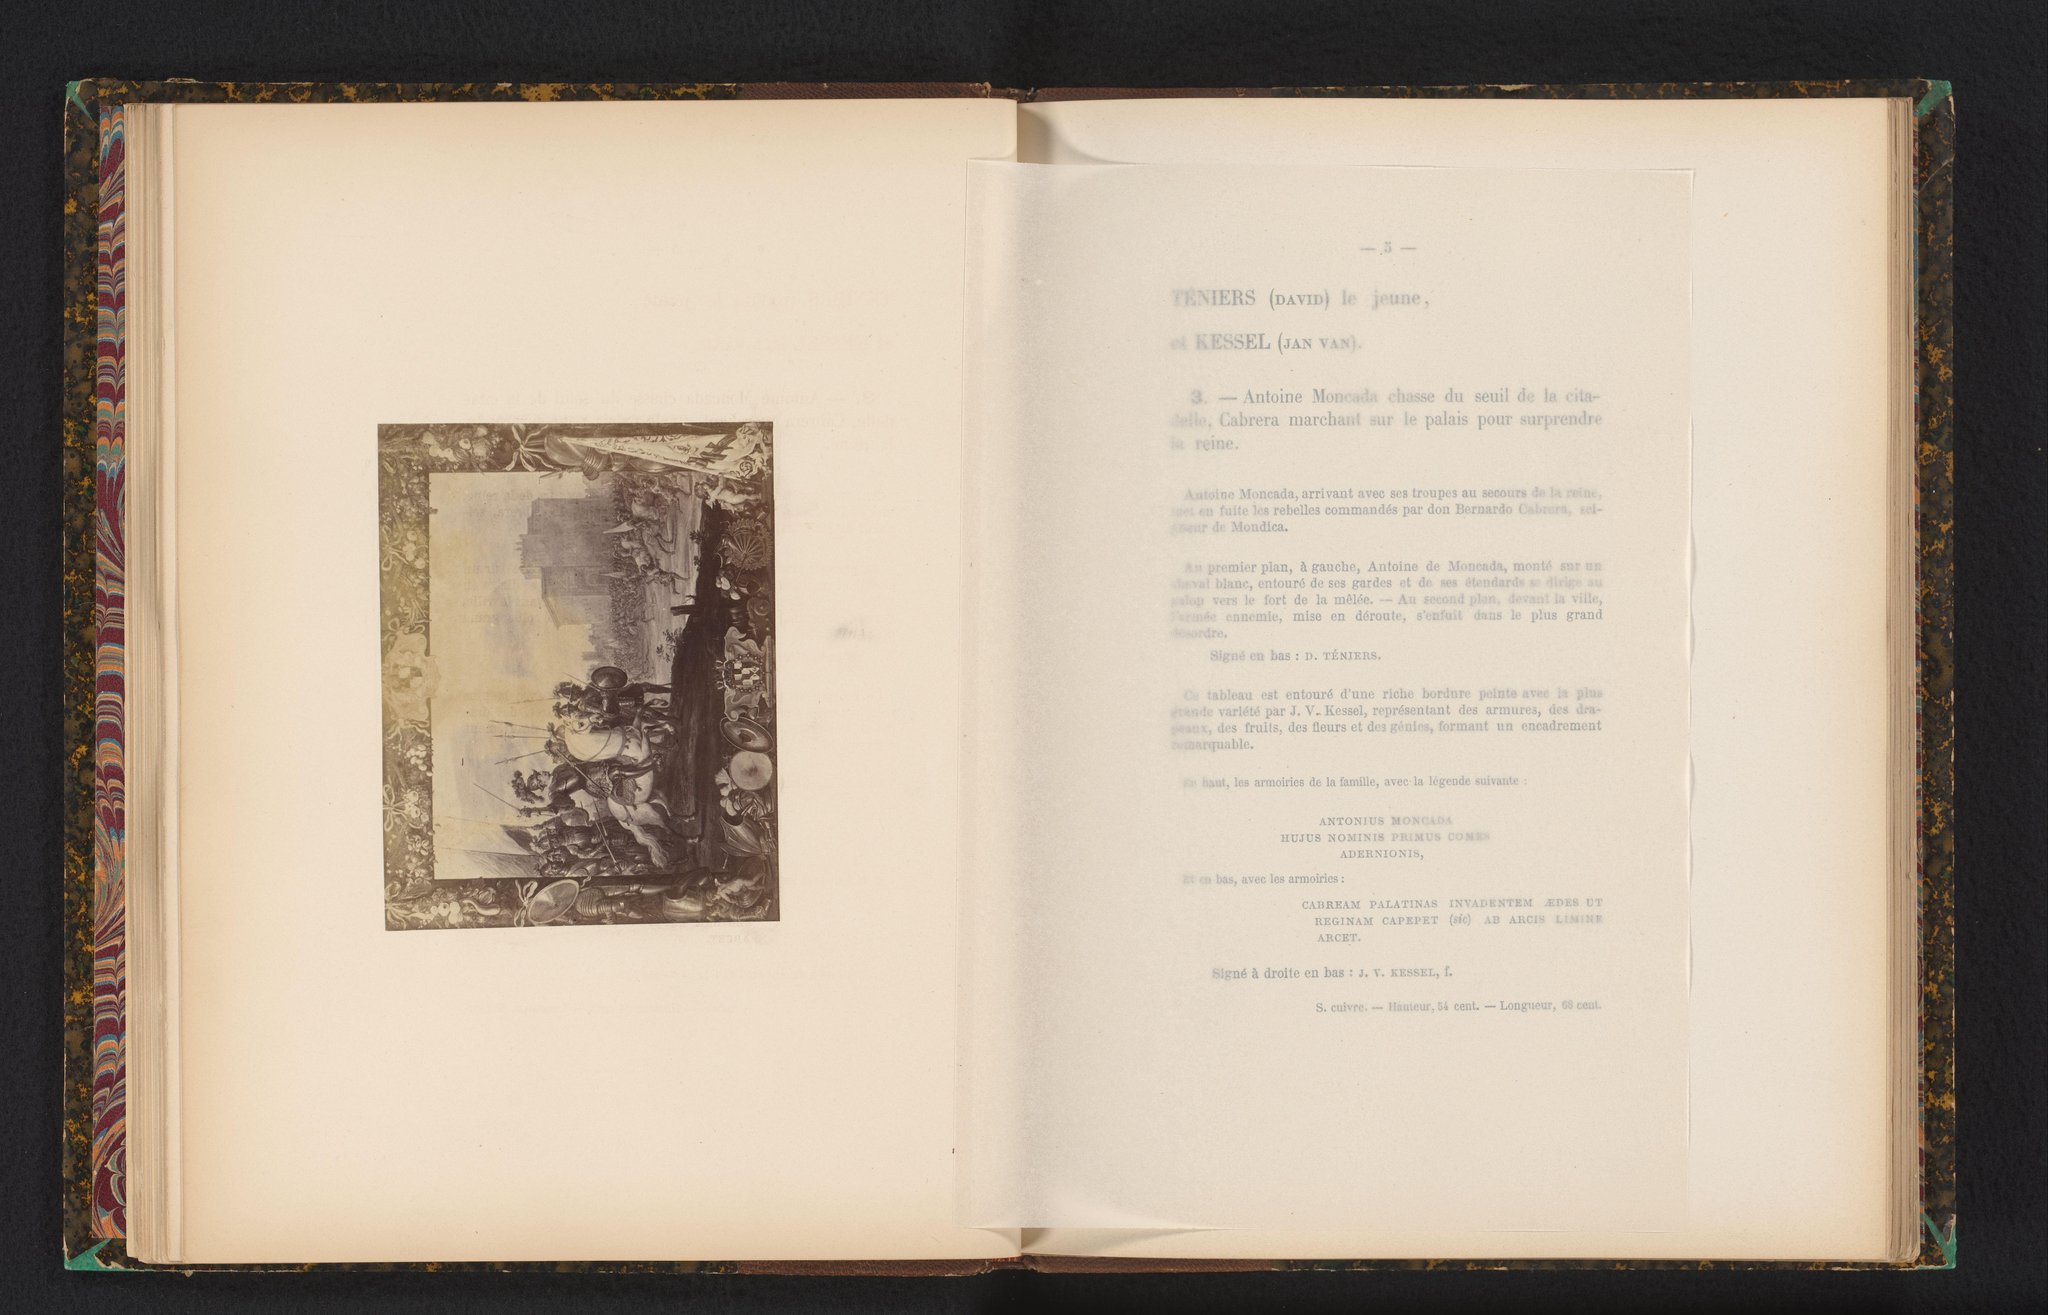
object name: photograph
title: Fotoreproductie van een schilderij van Antonius Moncada en zijn leger die de opstandelingen verdrijven door David Teniers en Jan van Kessel I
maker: Anonymous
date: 1865-1870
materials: photographic support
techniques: albumen print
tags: unsuccessful revolution or revolt, suppression of revolutionary activity